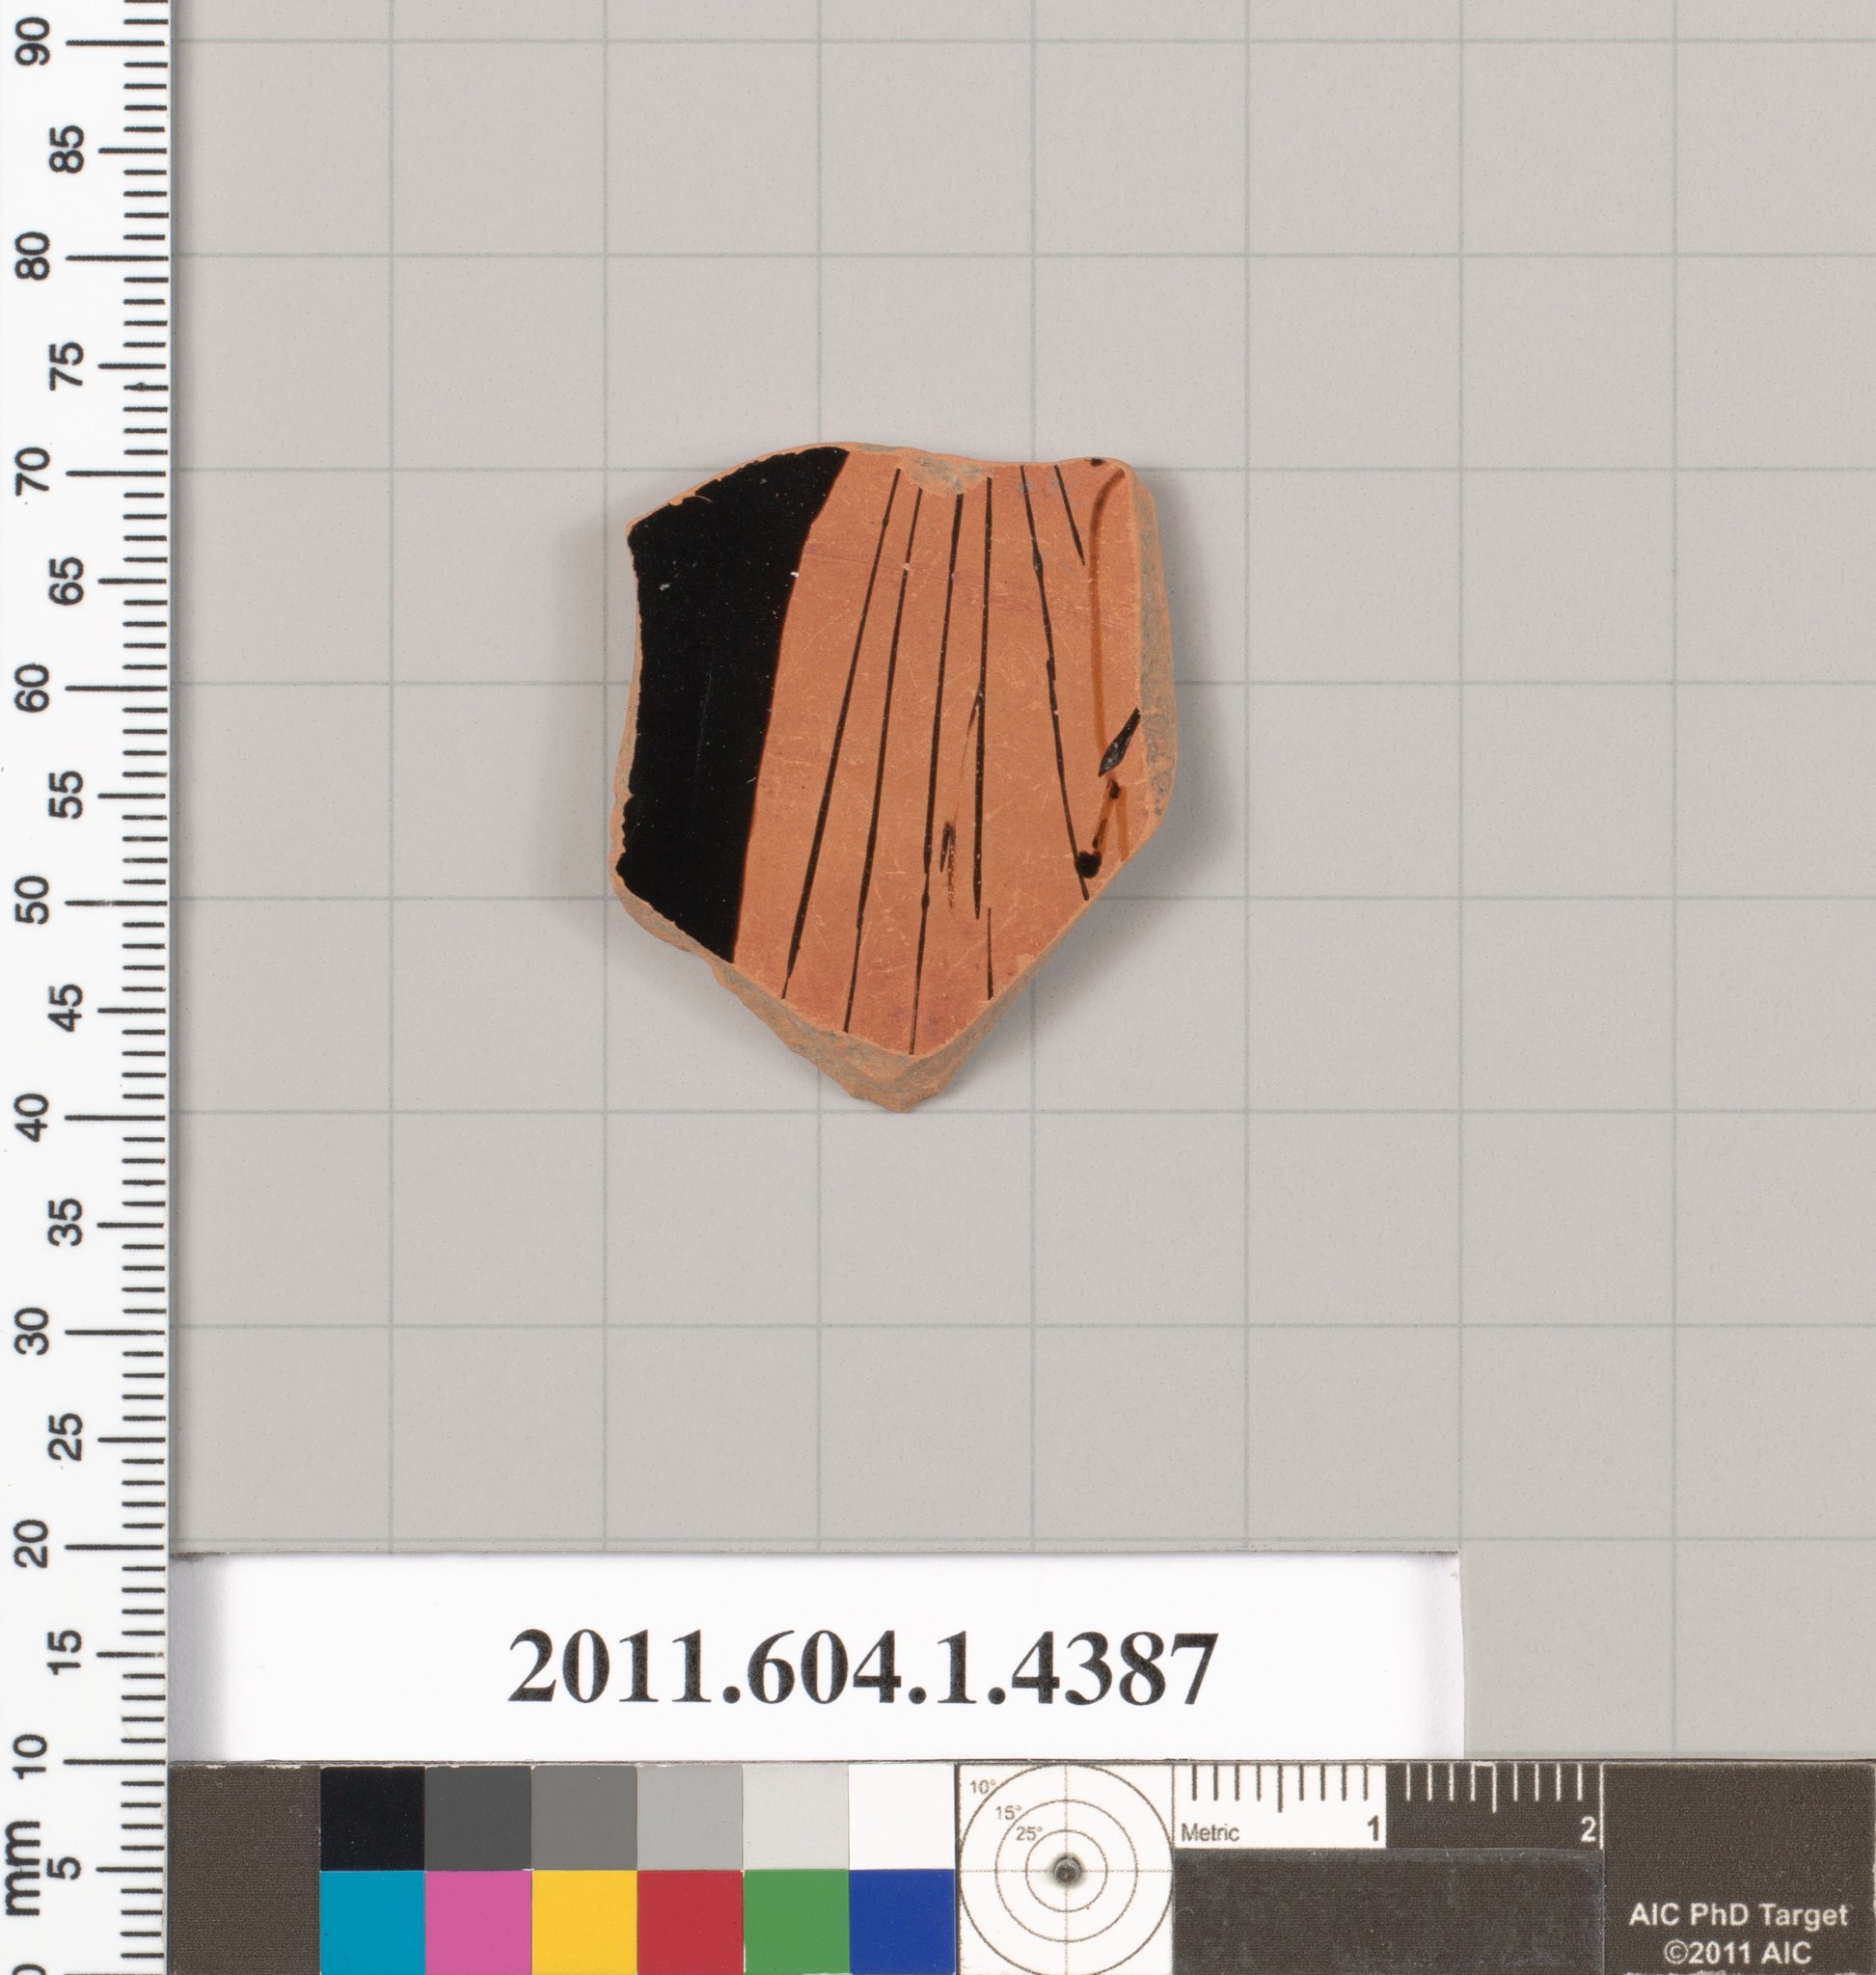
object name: kylix fragment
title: Terracotta fragment of a kylix (drinking cup)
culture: greek, attic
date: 475-451 BCE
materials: terracotta